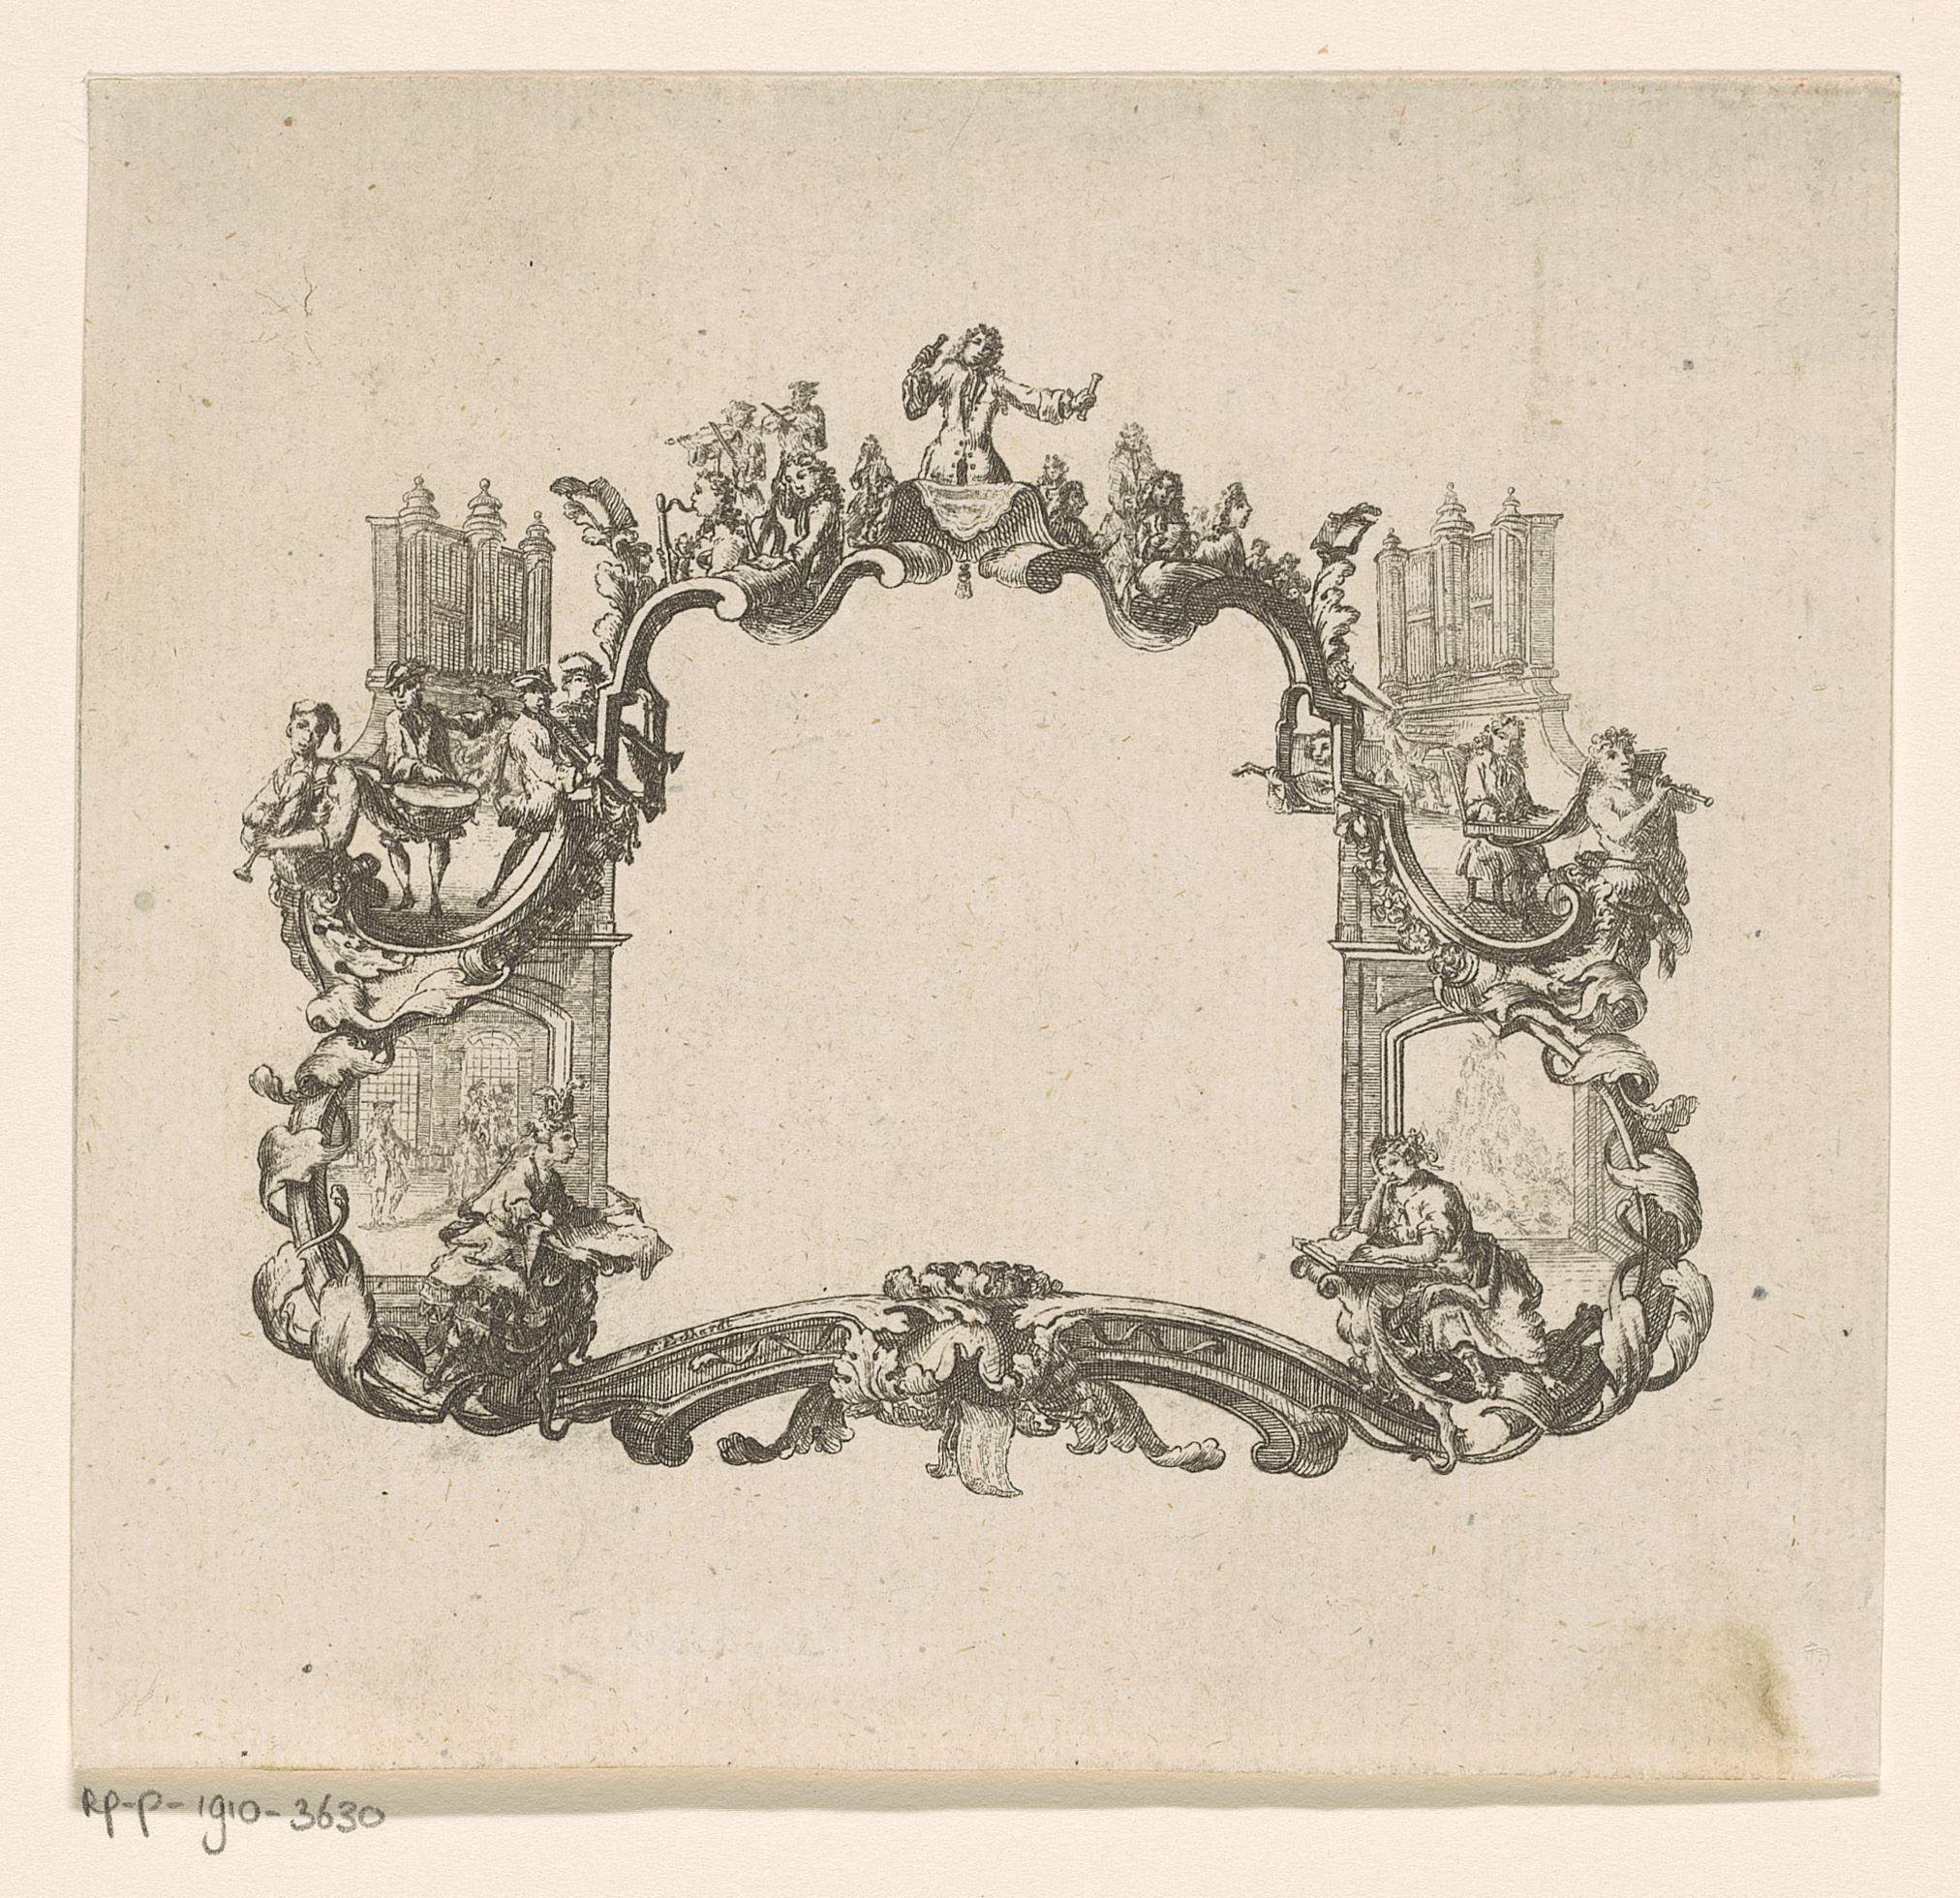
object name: print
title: Cartouche met musicerende en componerende figuren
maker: ferdinand eckhardt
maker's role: print maker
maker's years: 1876-1952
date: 1886-1910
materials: paper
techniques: etching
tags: acanthus ~ ornament, large group of musicians, orchestra, ornament ~ cartouche, conductor ~ music, composer